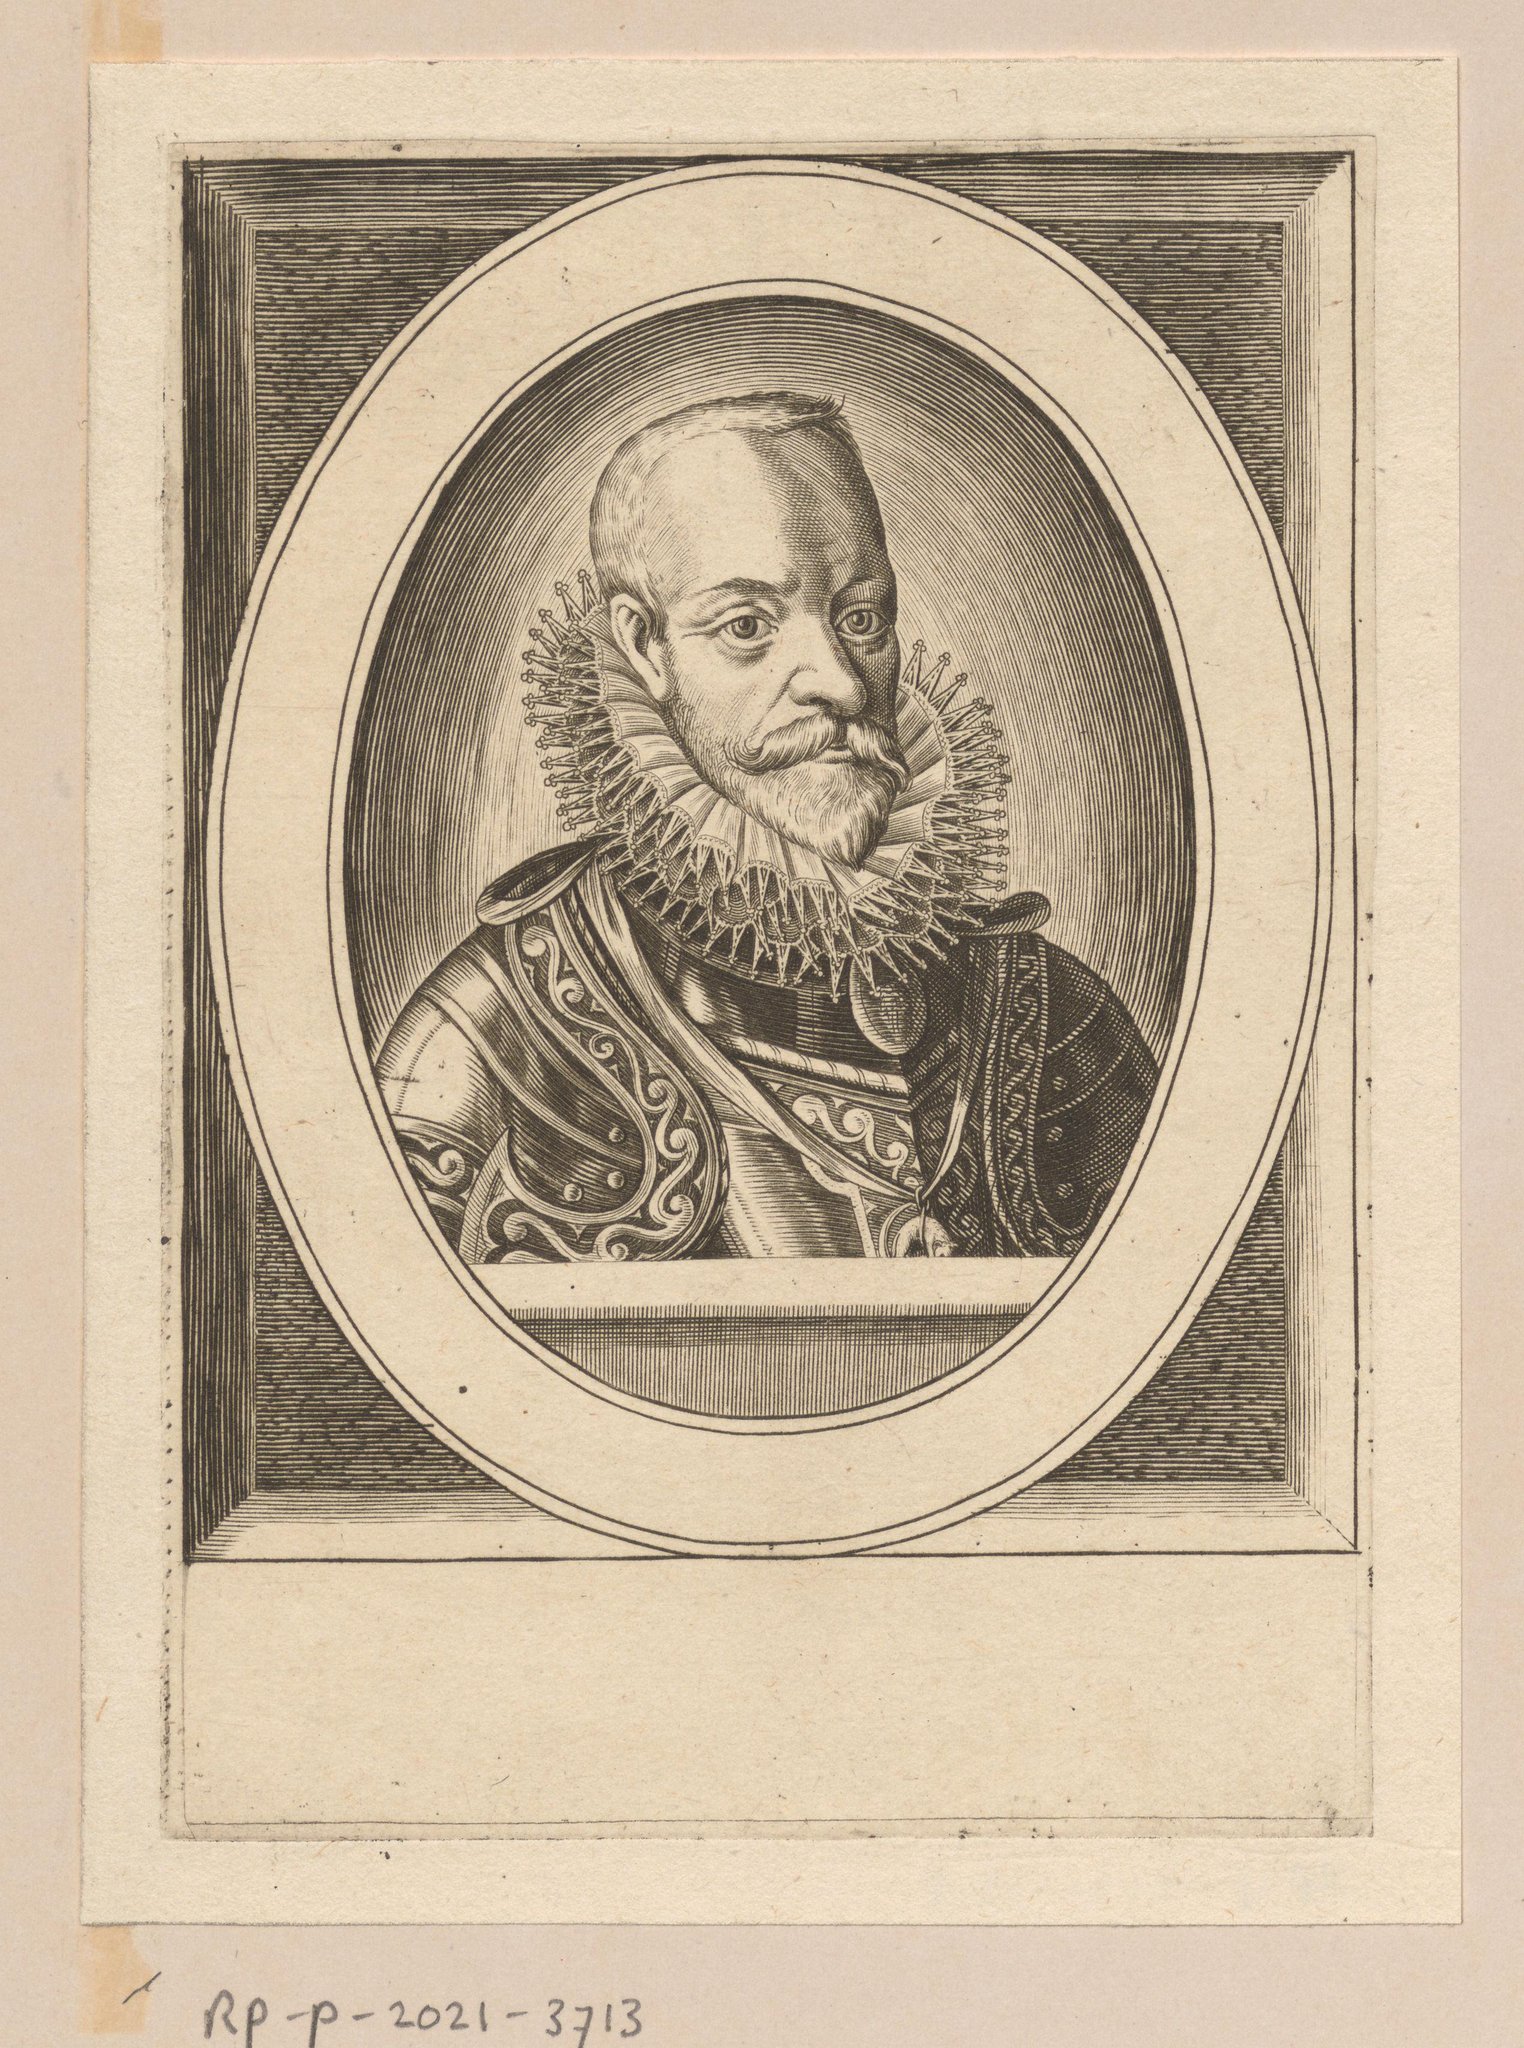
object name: book illustration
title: Portret van Peter Ernst I van Mansfeld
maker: Anonymous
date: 1600-1699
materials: paper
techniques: engraving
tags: ornament ~ medallion, armour, historical persons, knighthood order of the golden fleece - insignia of a knighthood order, e.g.: badge, chain (with name of order)